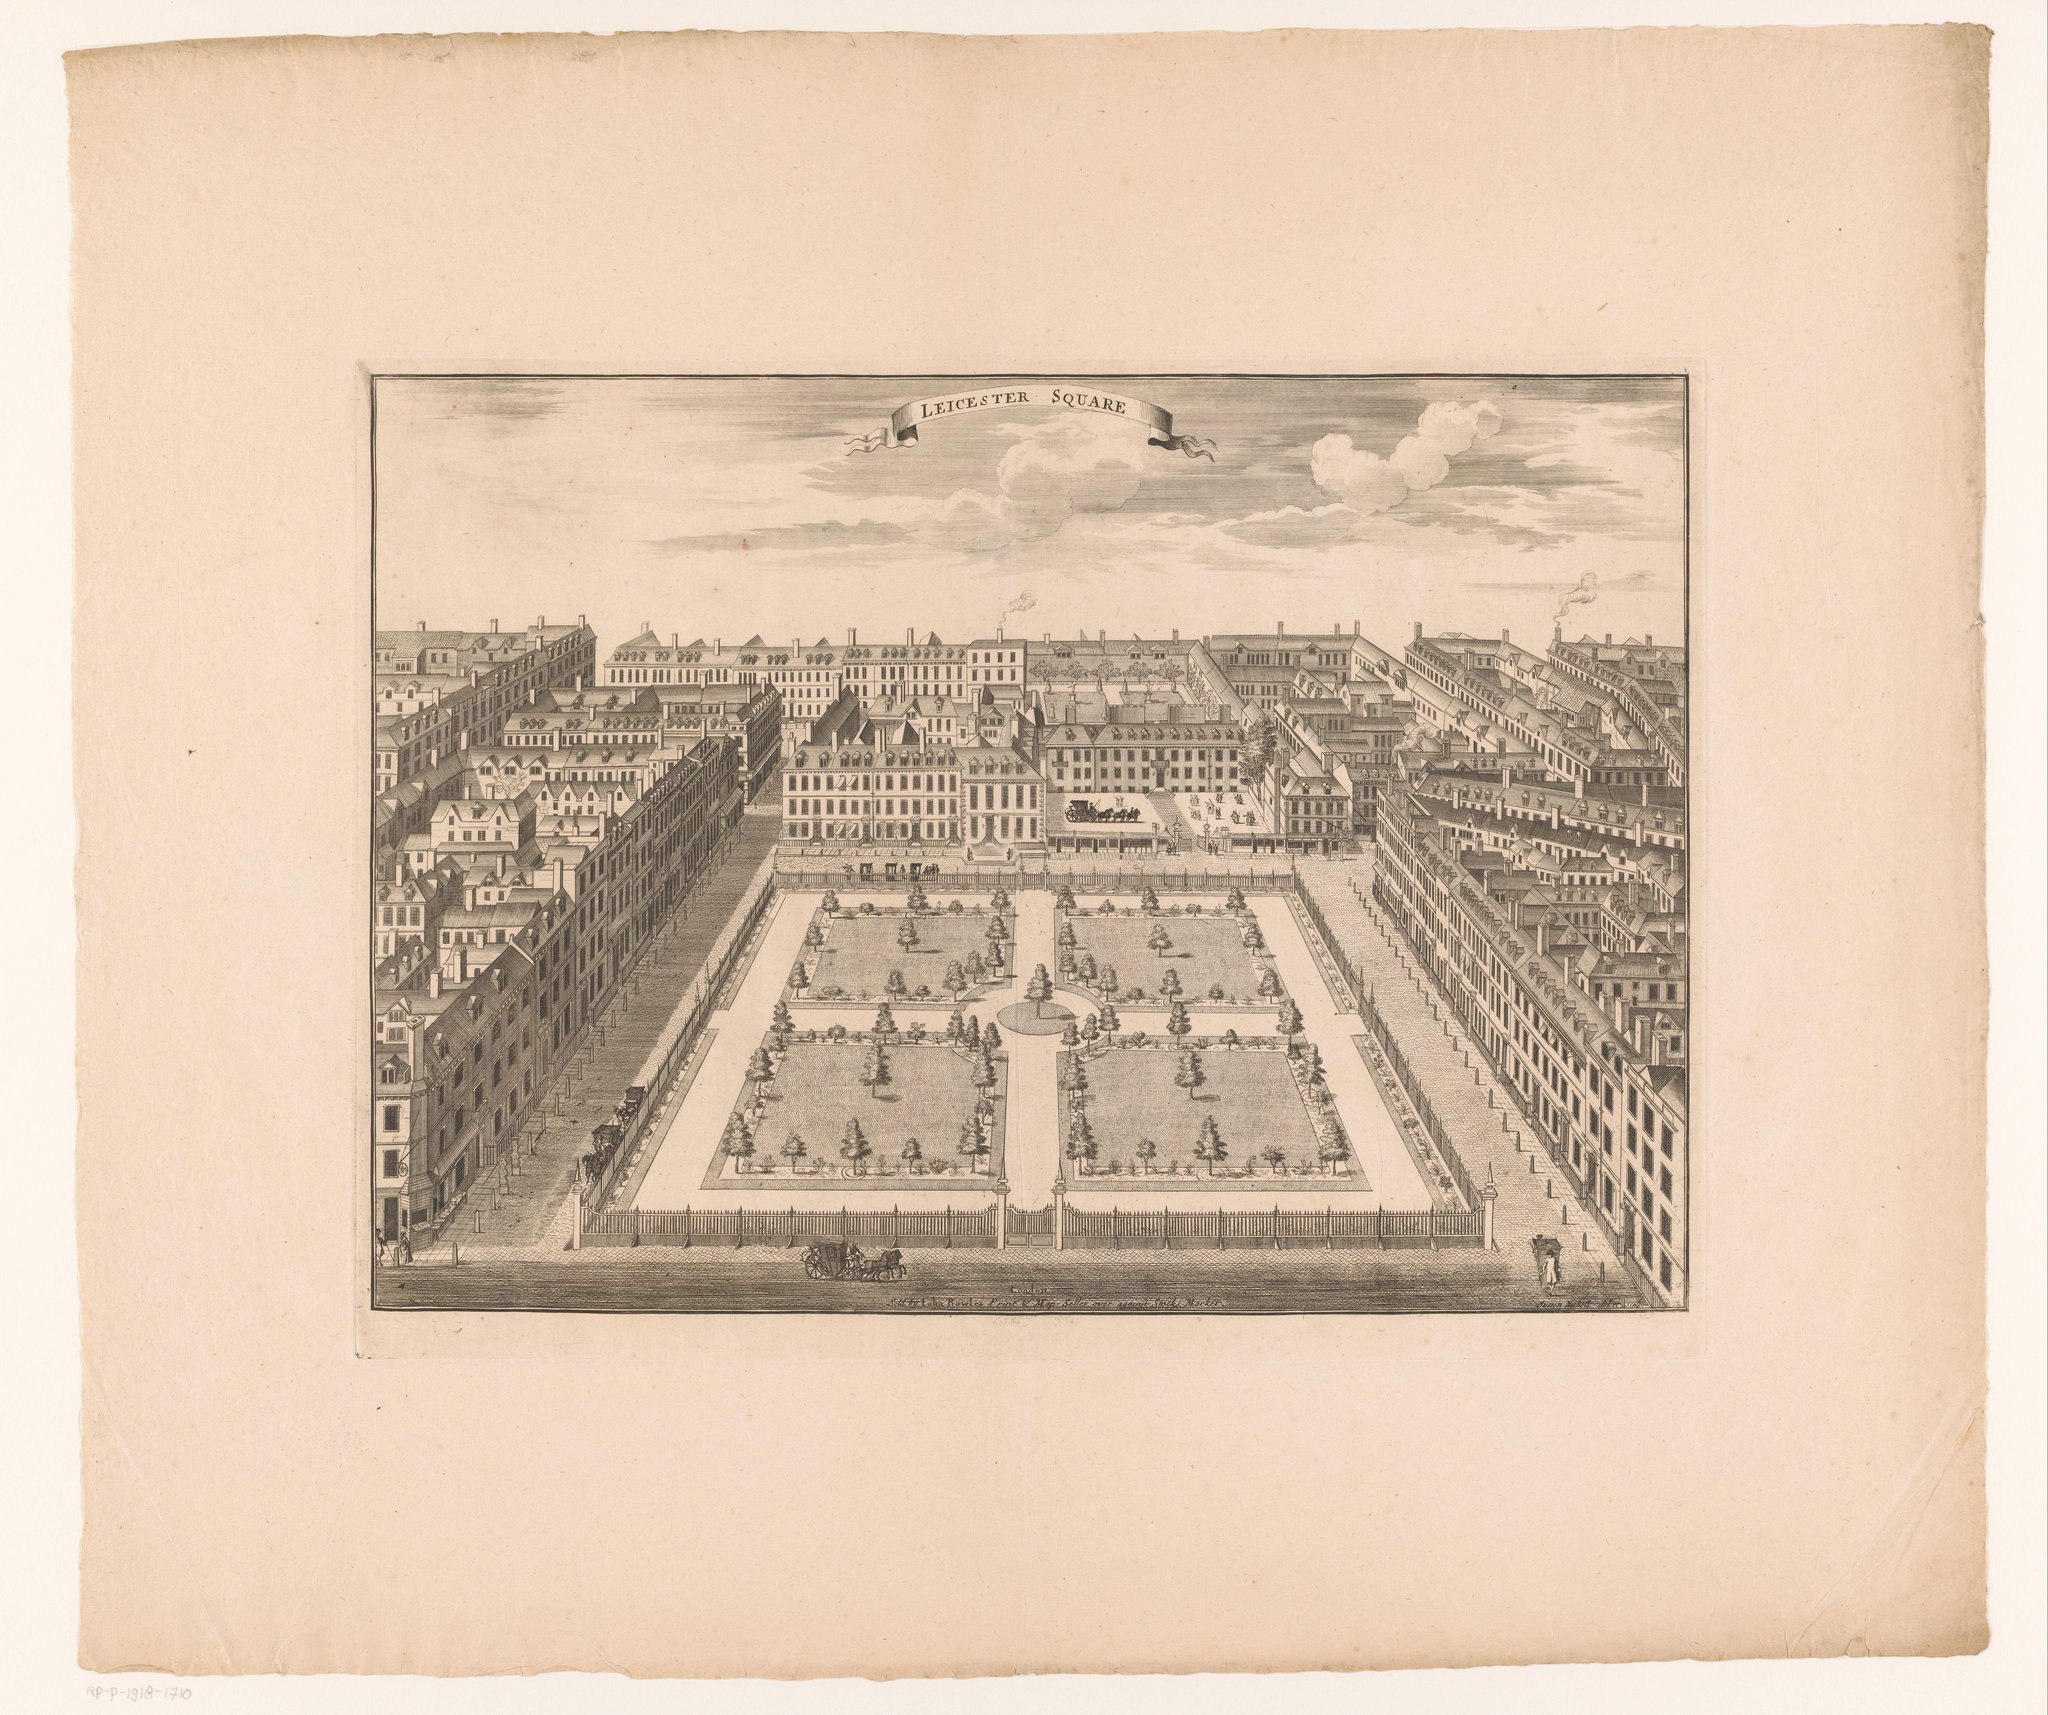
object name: print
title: Leicester Square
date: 1720-1731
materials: paper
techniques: engraving, etching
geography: london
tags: square, place, circus, etc. (+ city(-scape) with figures, staffage)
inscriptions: collector's mark: Lugt 2233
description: Deze reeks werd voor het eerst compleet uitgegeven in 1731, al zijn de losse prenten al voor die tijd uitgebracht. De meeste prenten zijn vervaardigd door Sutton Nicholls. De serie werd aangeboden voor verkoop door John Bowles in zijn catalogus 1753, op pagina 76, nummer 16.